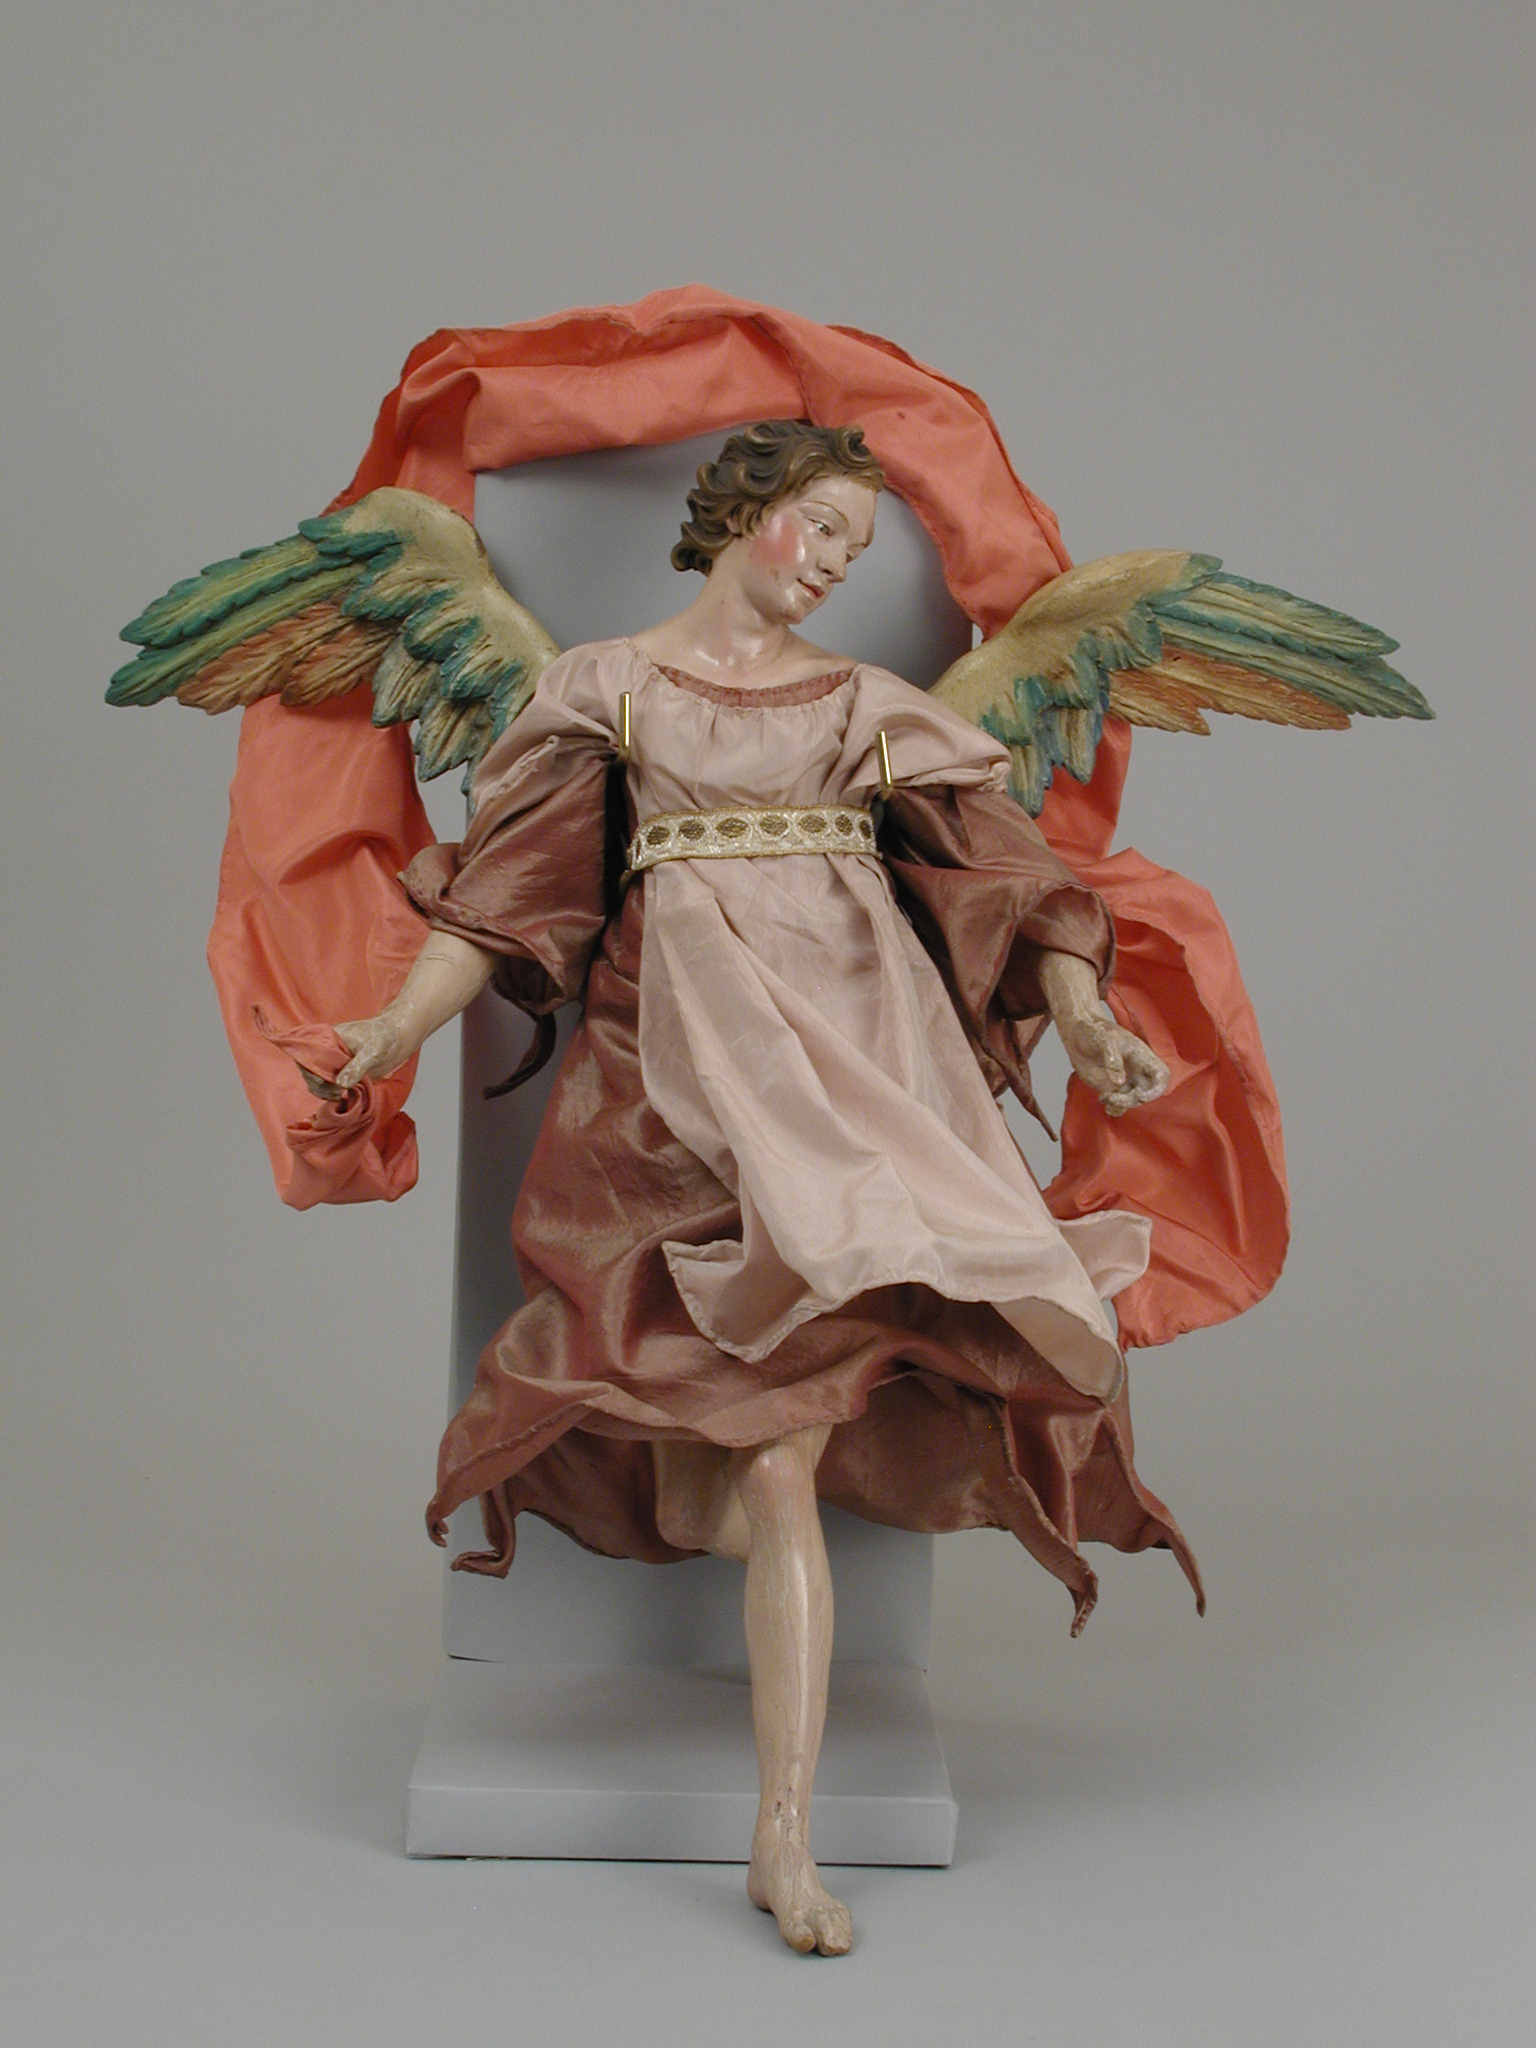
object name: crèche figure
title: Angel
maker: lorenzo mosca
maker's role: maker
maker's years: 1689-1789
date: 1701-1800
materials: terracotta, fiber, metal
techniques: polychrome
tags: angels